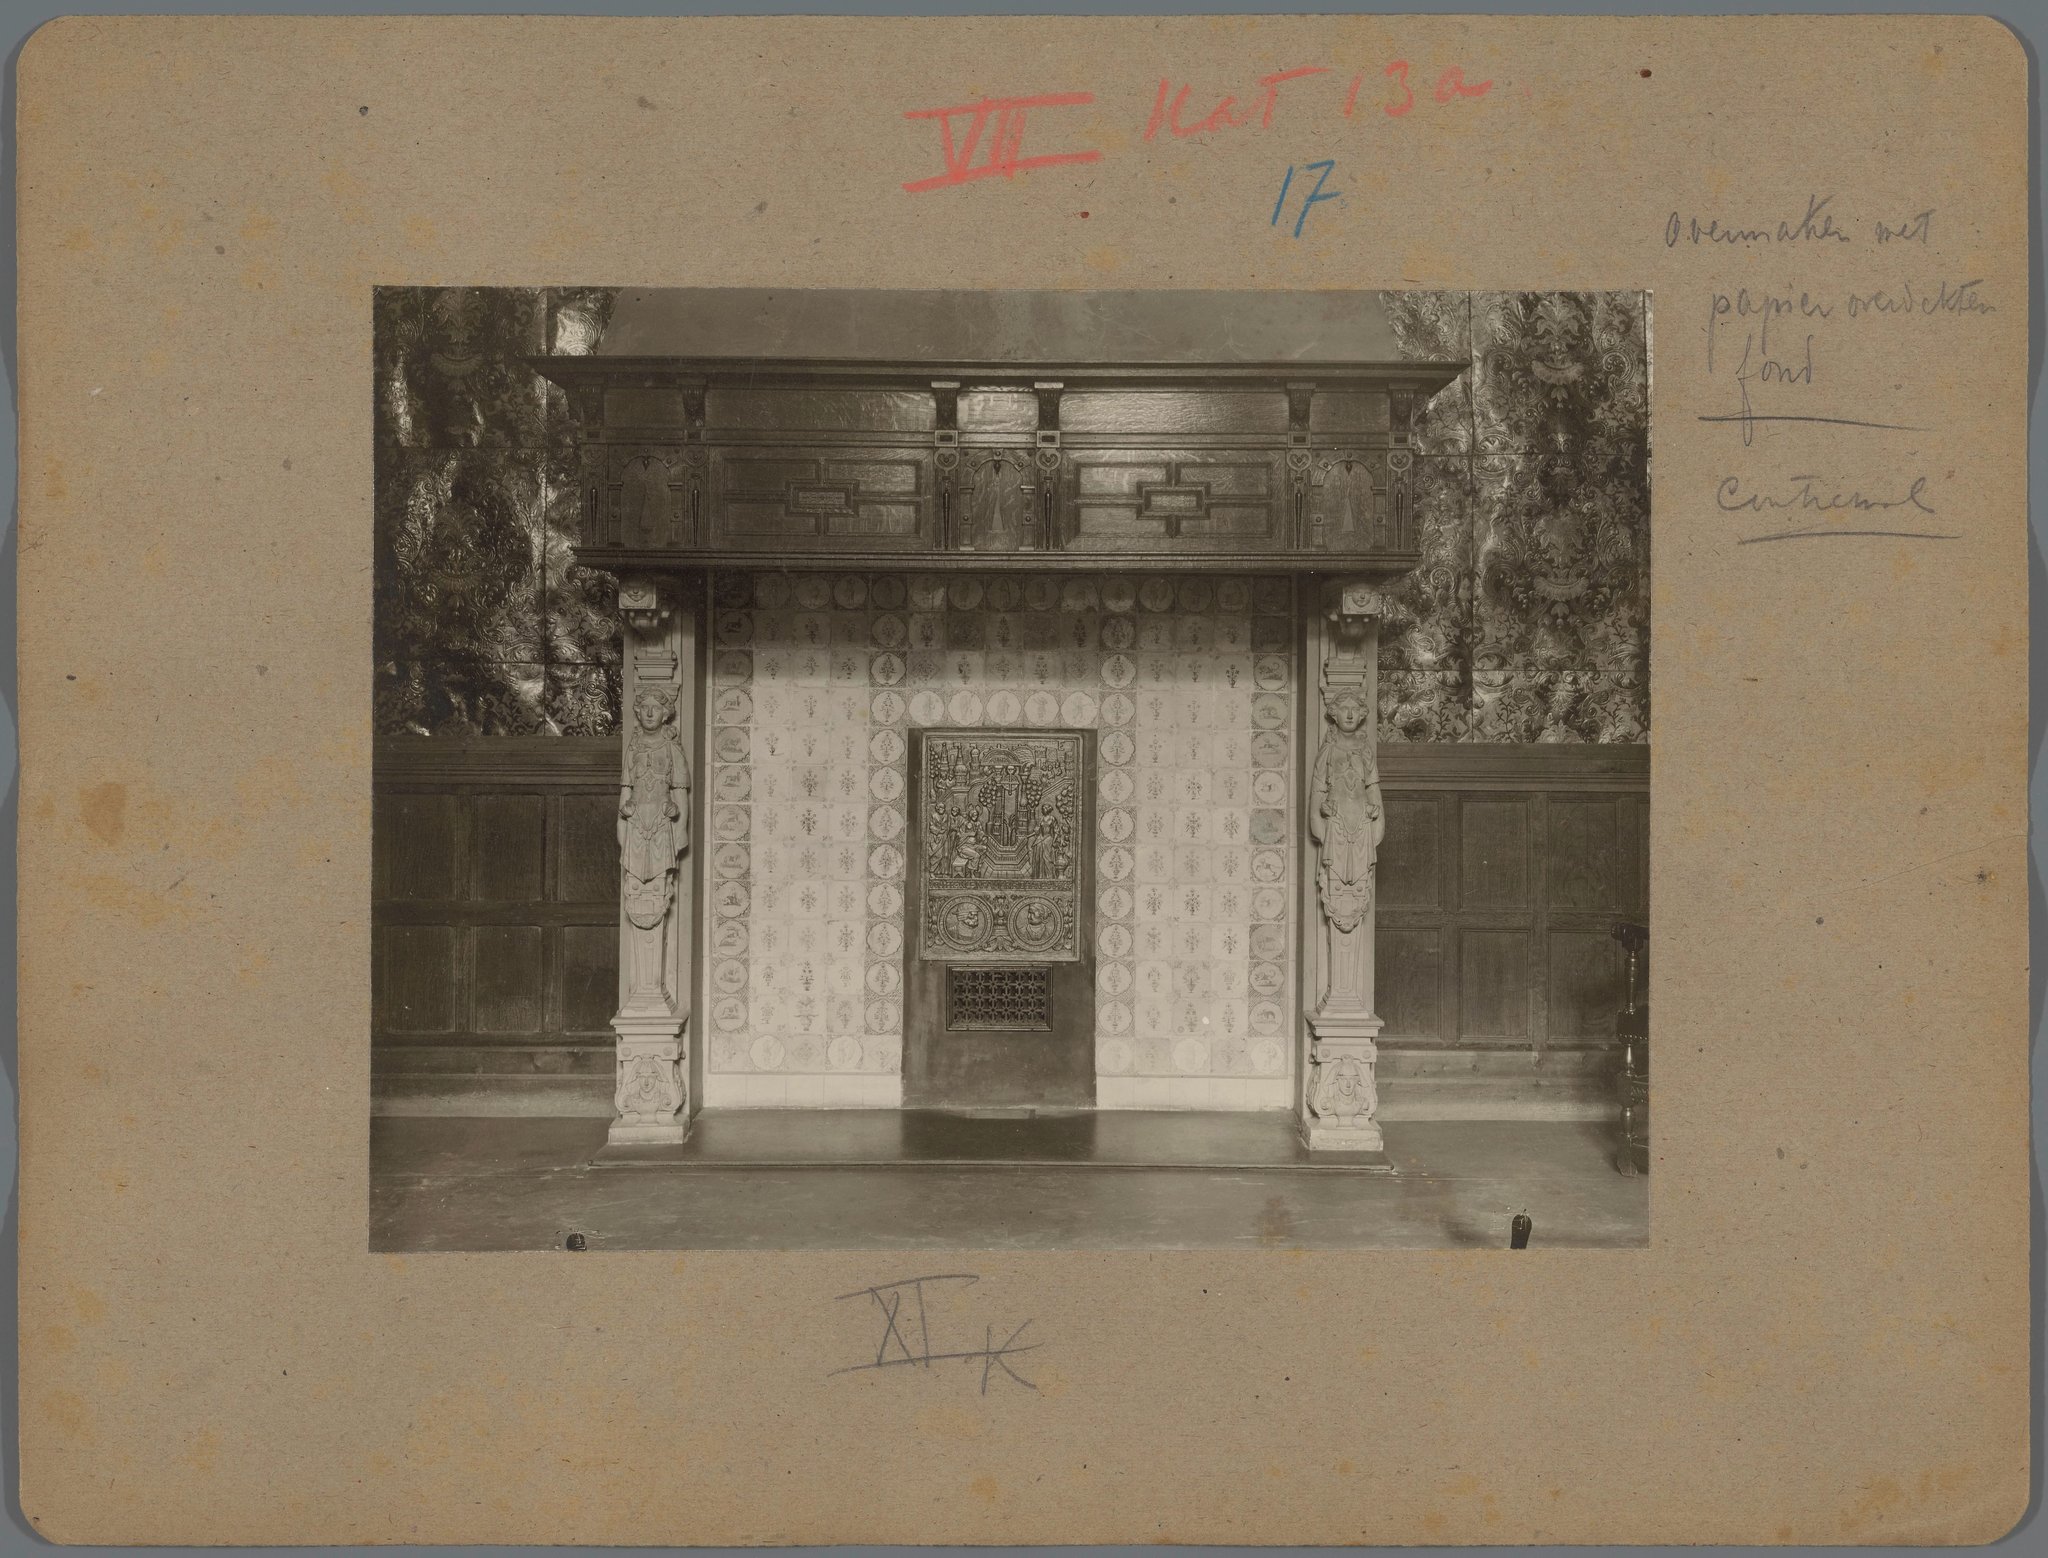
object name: photograph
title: Schouw met kariatiden en een haardsteen met vermoedelijk een christelijke voorstelling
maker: Anonymous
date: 1875-1900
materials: cardboard, photographic support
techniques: gelatin silver print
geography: europe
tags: caryatids ~ architecture, open hearth, fire-place, tiles, bricks ~ building material, europe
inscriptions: number: ‘VII’, number: ‘Kat 13a’, collector's mark: ‘INSTITUUT VOOR KUNST-NIJVERHEIDSONDERWIJS GABRIËL METSUSTRAAT No. 16 AMSTERDAM’, number: ‘XI’, number: ‘17’, collector's mark: ‘KUNSTNIJVERHEIDSCHOOL QUELLINUS AMSTERDAM FRANS HALSSTRAAT 14.’